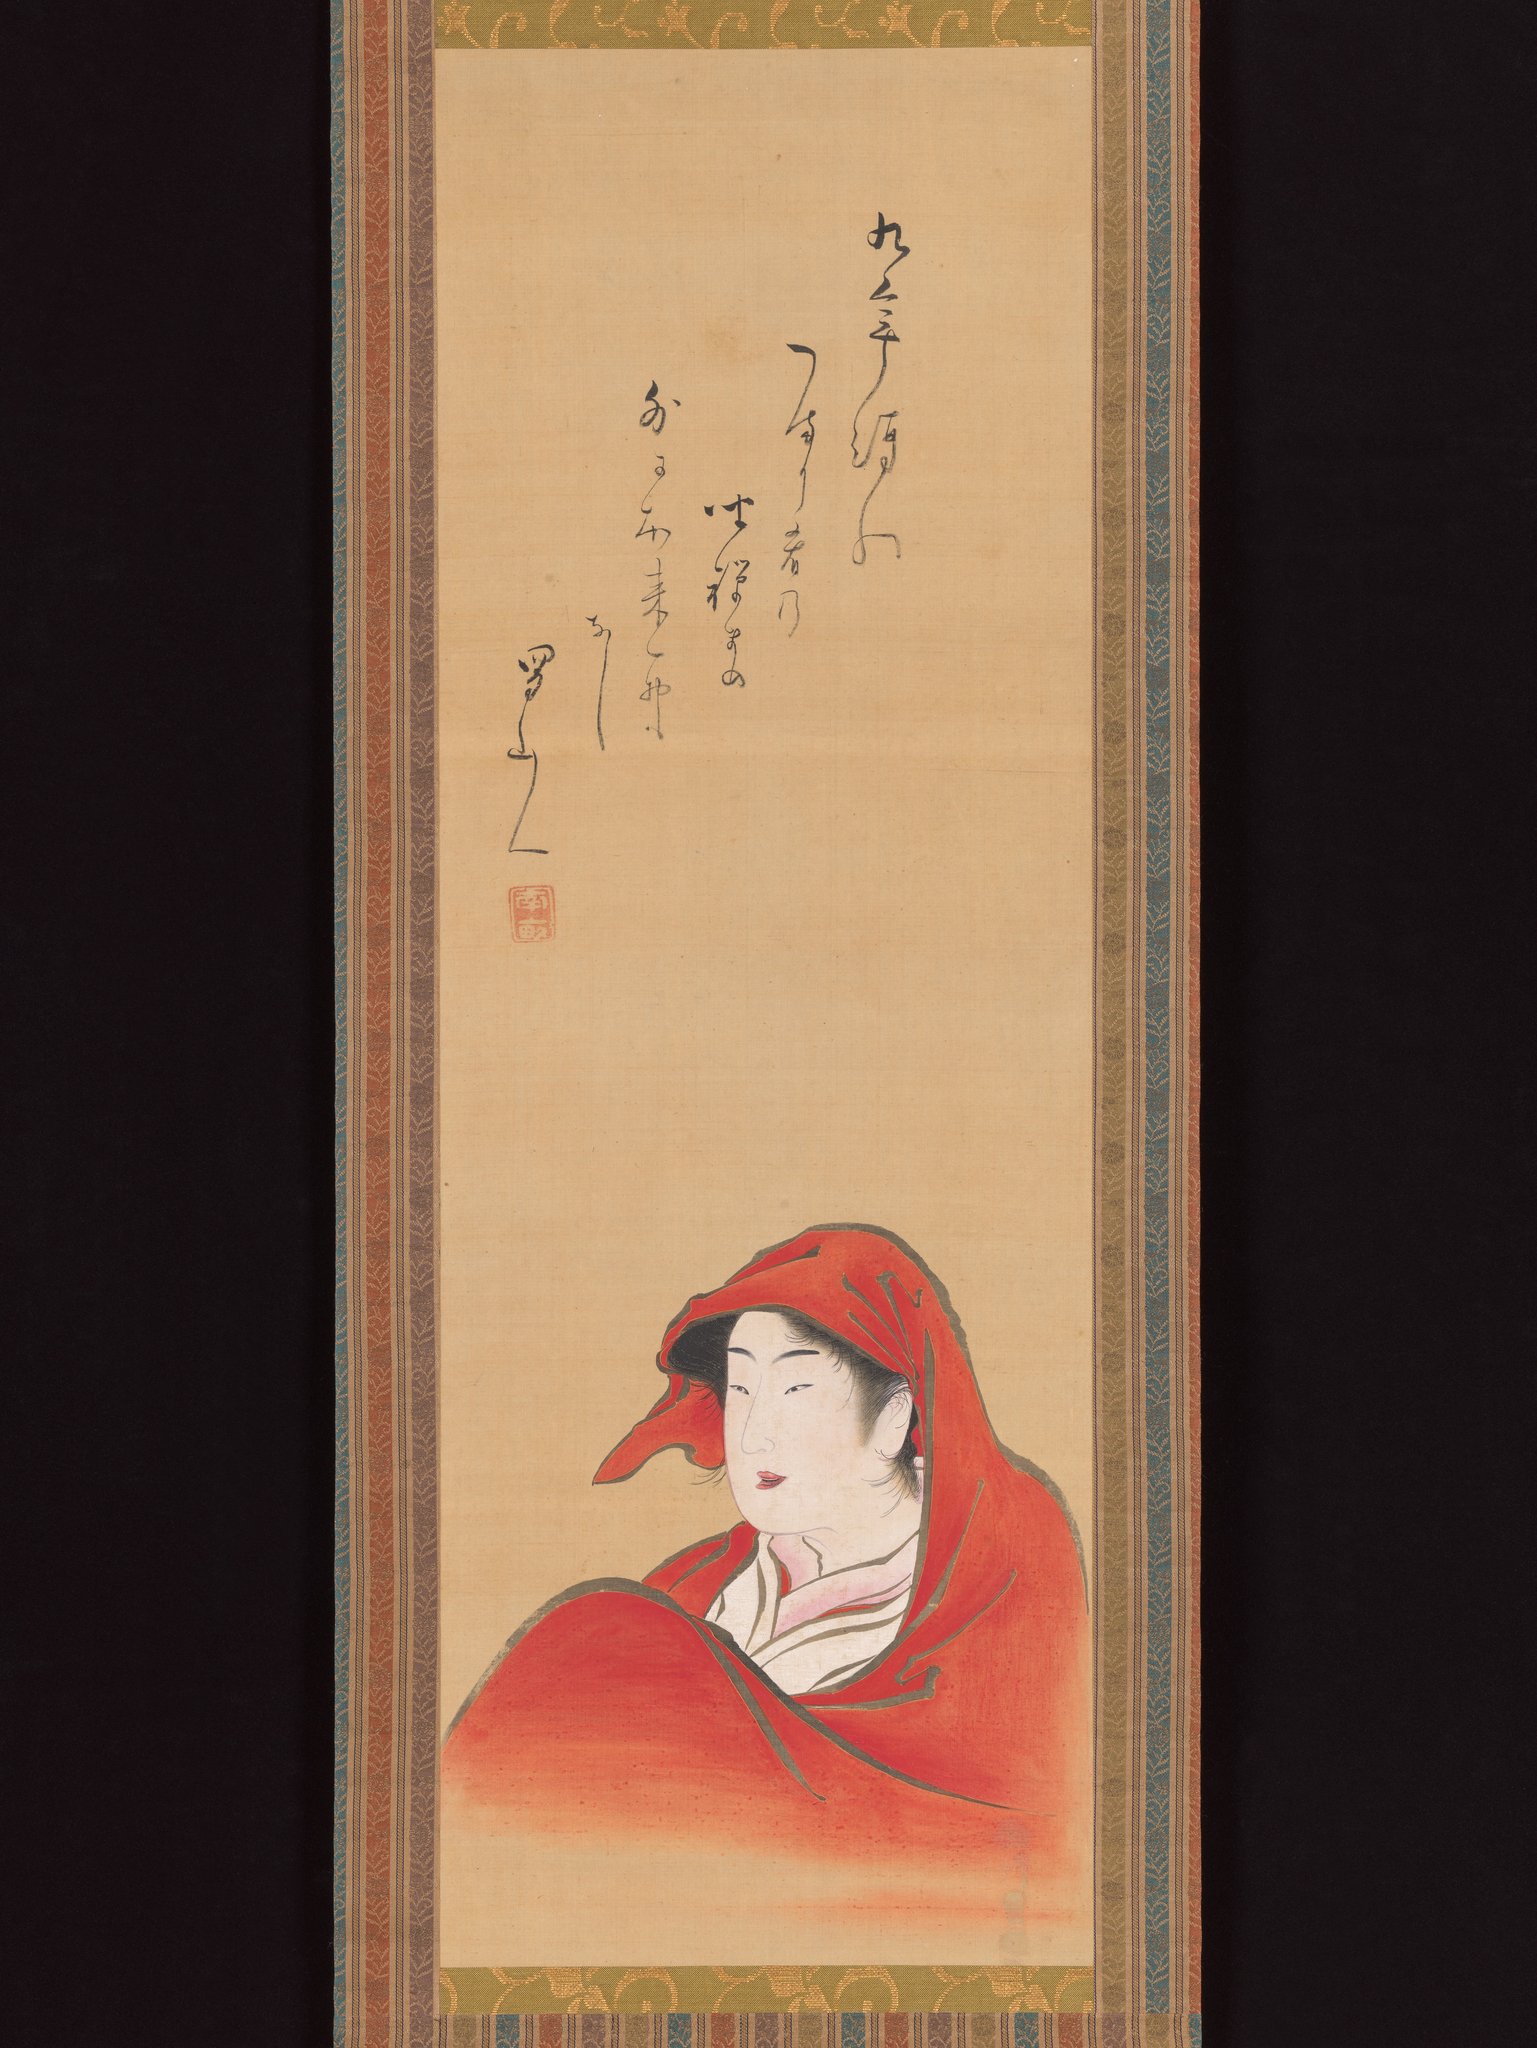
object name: hanging scroll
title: Courtesan as Daruma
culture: japanese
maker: utagawa toyoharu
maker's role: artist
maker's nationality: japanese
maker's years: 1735-1814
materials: ink, paper